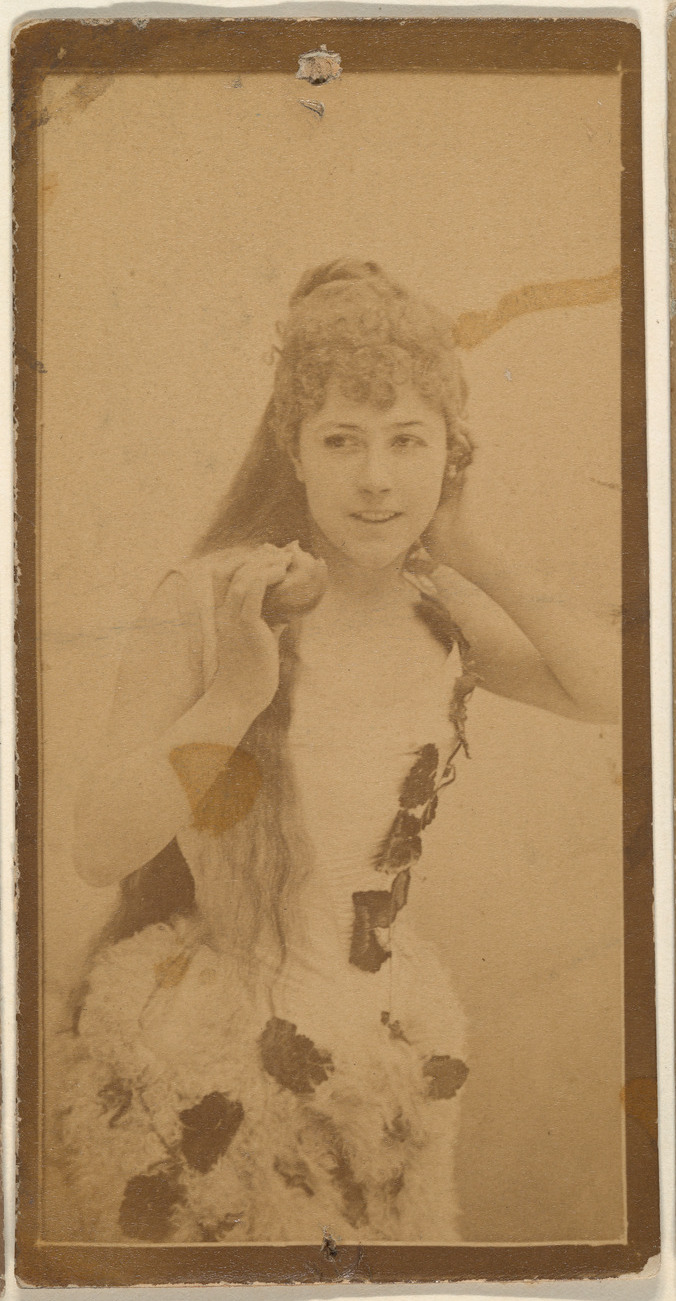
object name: photograph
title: Actress holding apple, from the Actresses series (N668)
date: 1888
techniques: albumen silver print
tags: apples,portraits,women,actresses